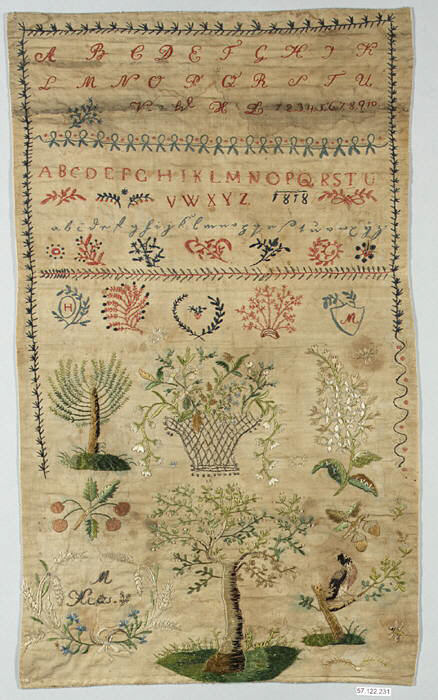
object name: sampler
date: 1818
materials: linen, metal thread, silk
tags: flowers,trees